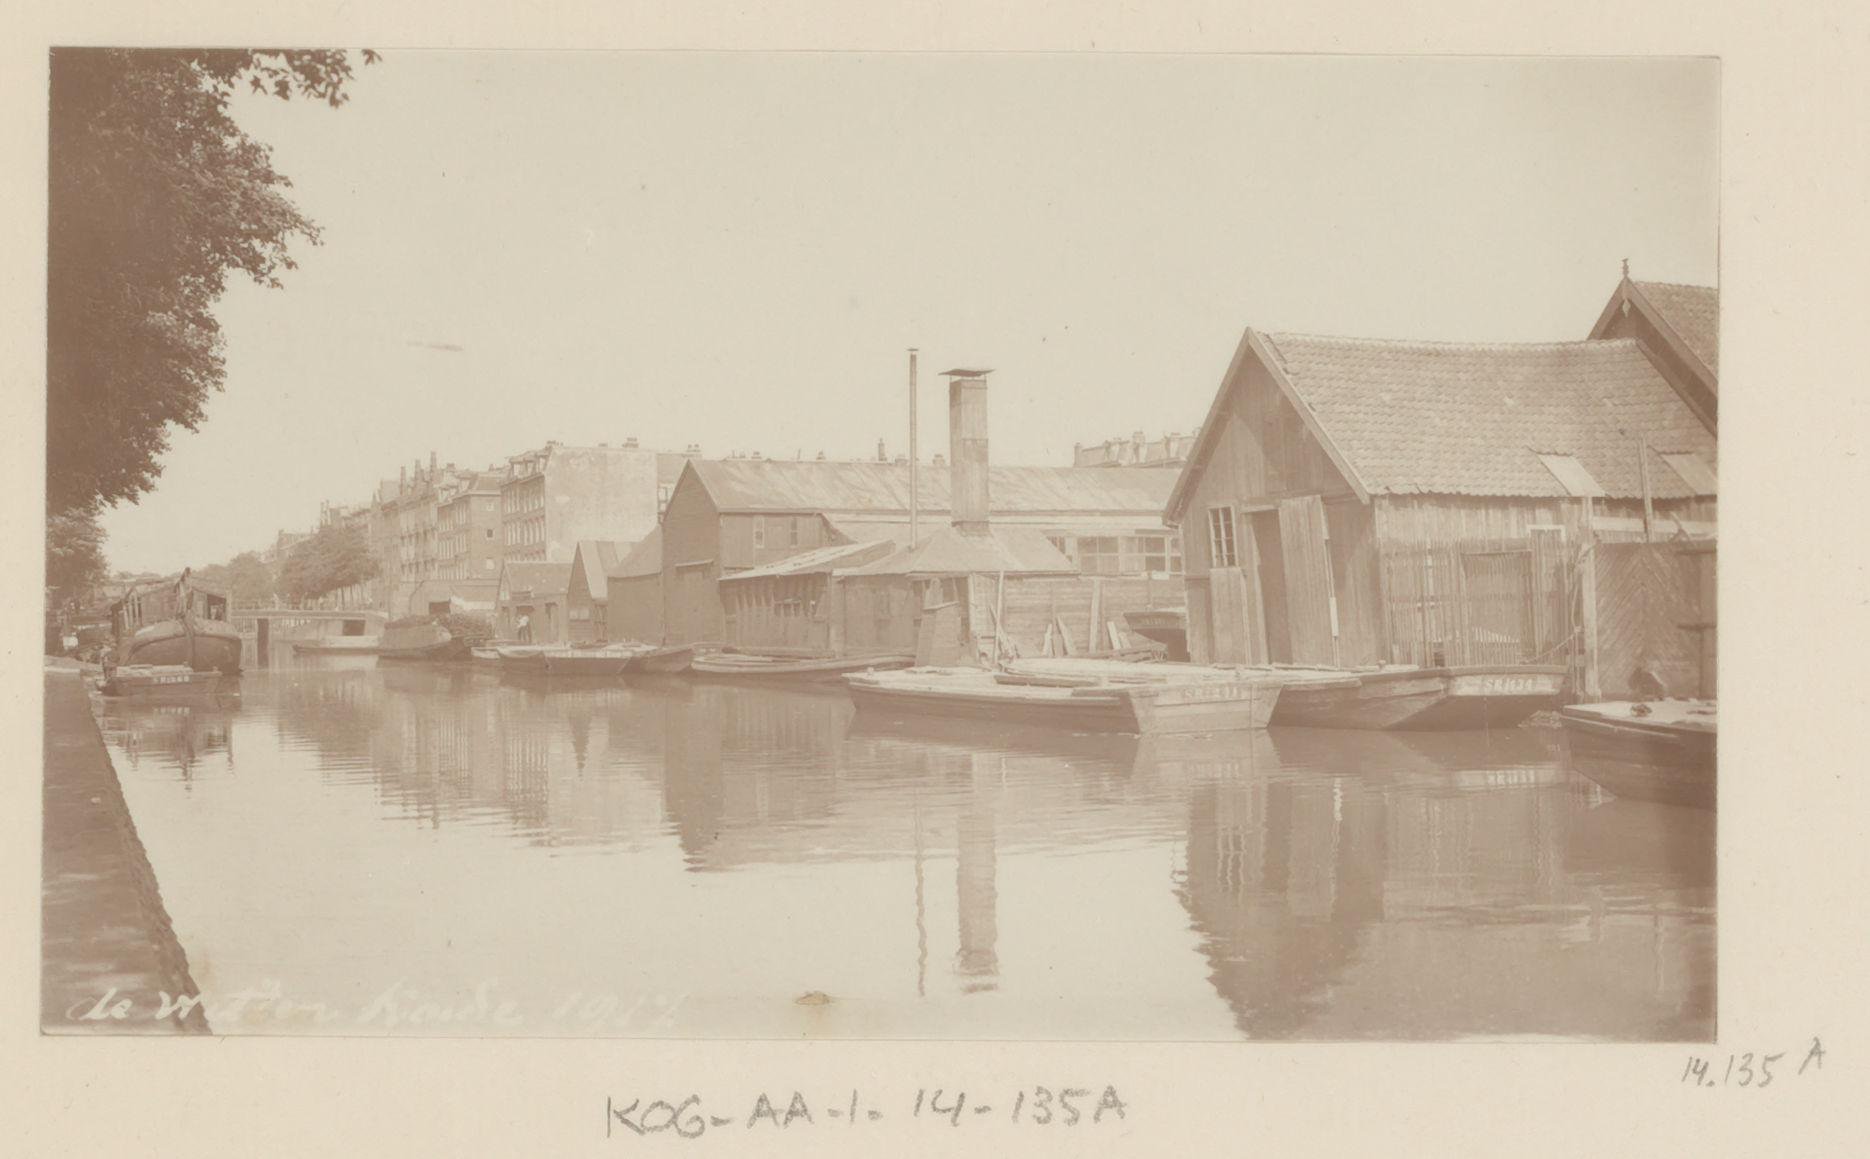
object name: photograph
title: Gezicht op de De Wittenkade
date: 1917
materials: cardboard, paper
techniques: albumen print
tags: city-view in general; 'veduta', canal, shed, street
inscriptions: collector's mark: ‘14 135AB’ Lugt 1641b, inscription: ‘De Wittenkade (Kostverlorenvaart) / in 1917. / April 1920. / Geschenk v/d Heer J. van Eck.’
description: Onderwerpsrubriek binnen de Atlas Amsterdam: Waal (Kromme en Oude), Walenpleintje, Warmoesgracht, Warmoesstraat, Waterlooplein, Westerdoksdijk, Westermarkt, Weteringschans, Willemspark, Willemsstraat, Wittenburg, Wittenkade (de), Wittenstraat (de).